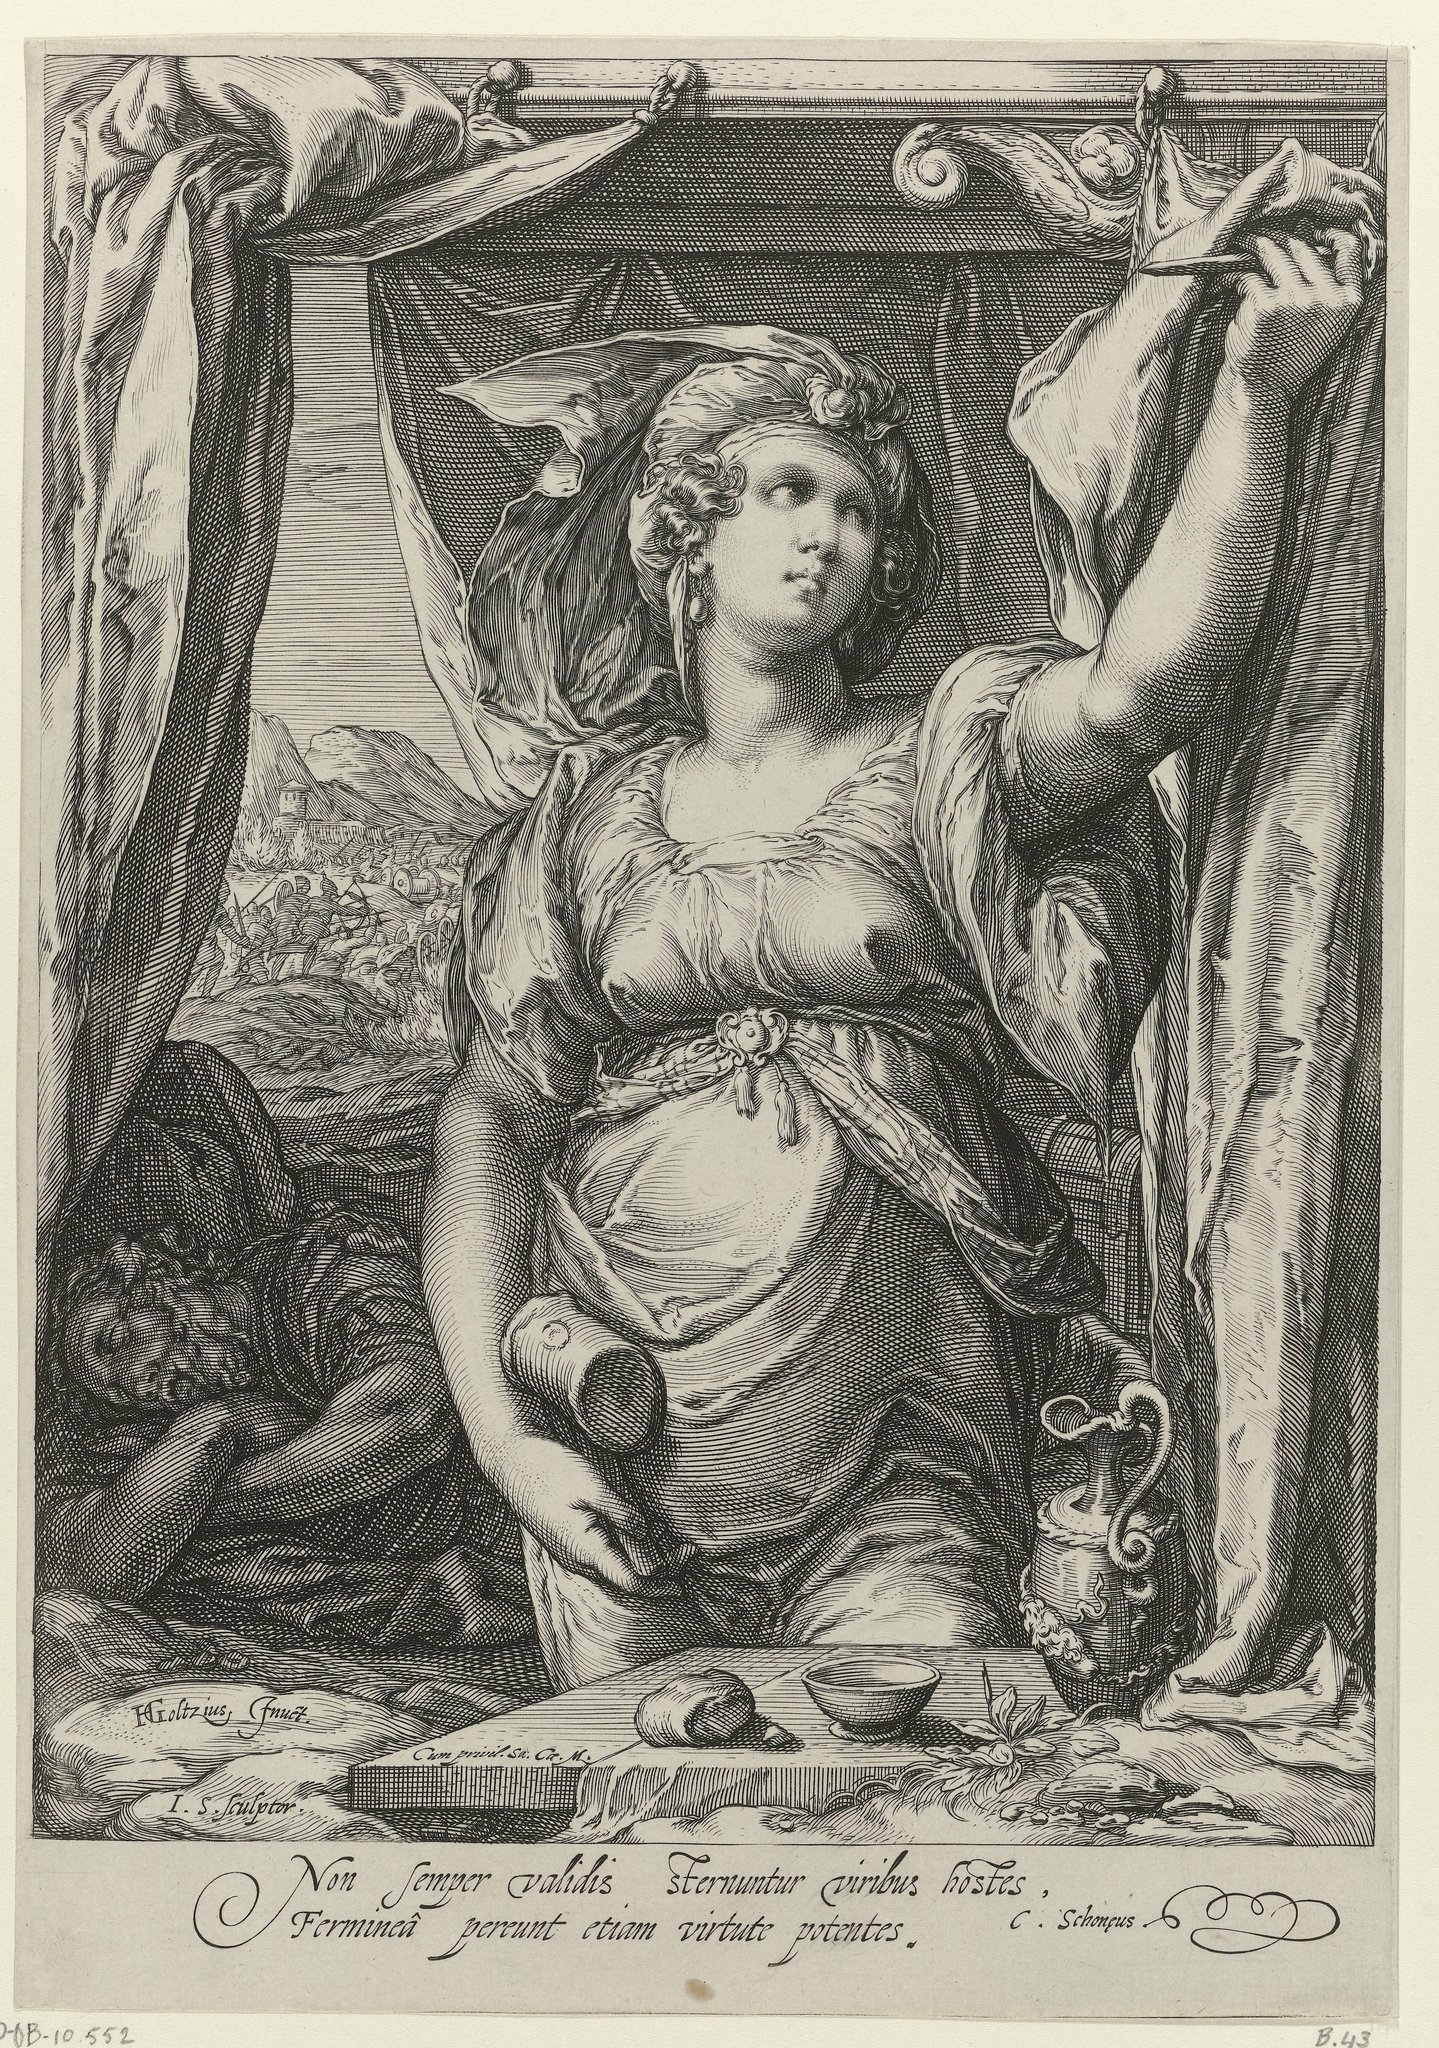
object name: print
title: Jaël en Sisera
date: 1575-1607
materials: paper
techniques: engraving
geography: northern netherlands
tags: jael takes a nail of the tent and a hammer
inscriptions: collector's mark: Lugt 240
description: Op de voorgrond Jaël, met een hamer en een tentpin. Op de achtergrond de slapende generaal Sisera. De prent heeft een Latijns onderschrift.